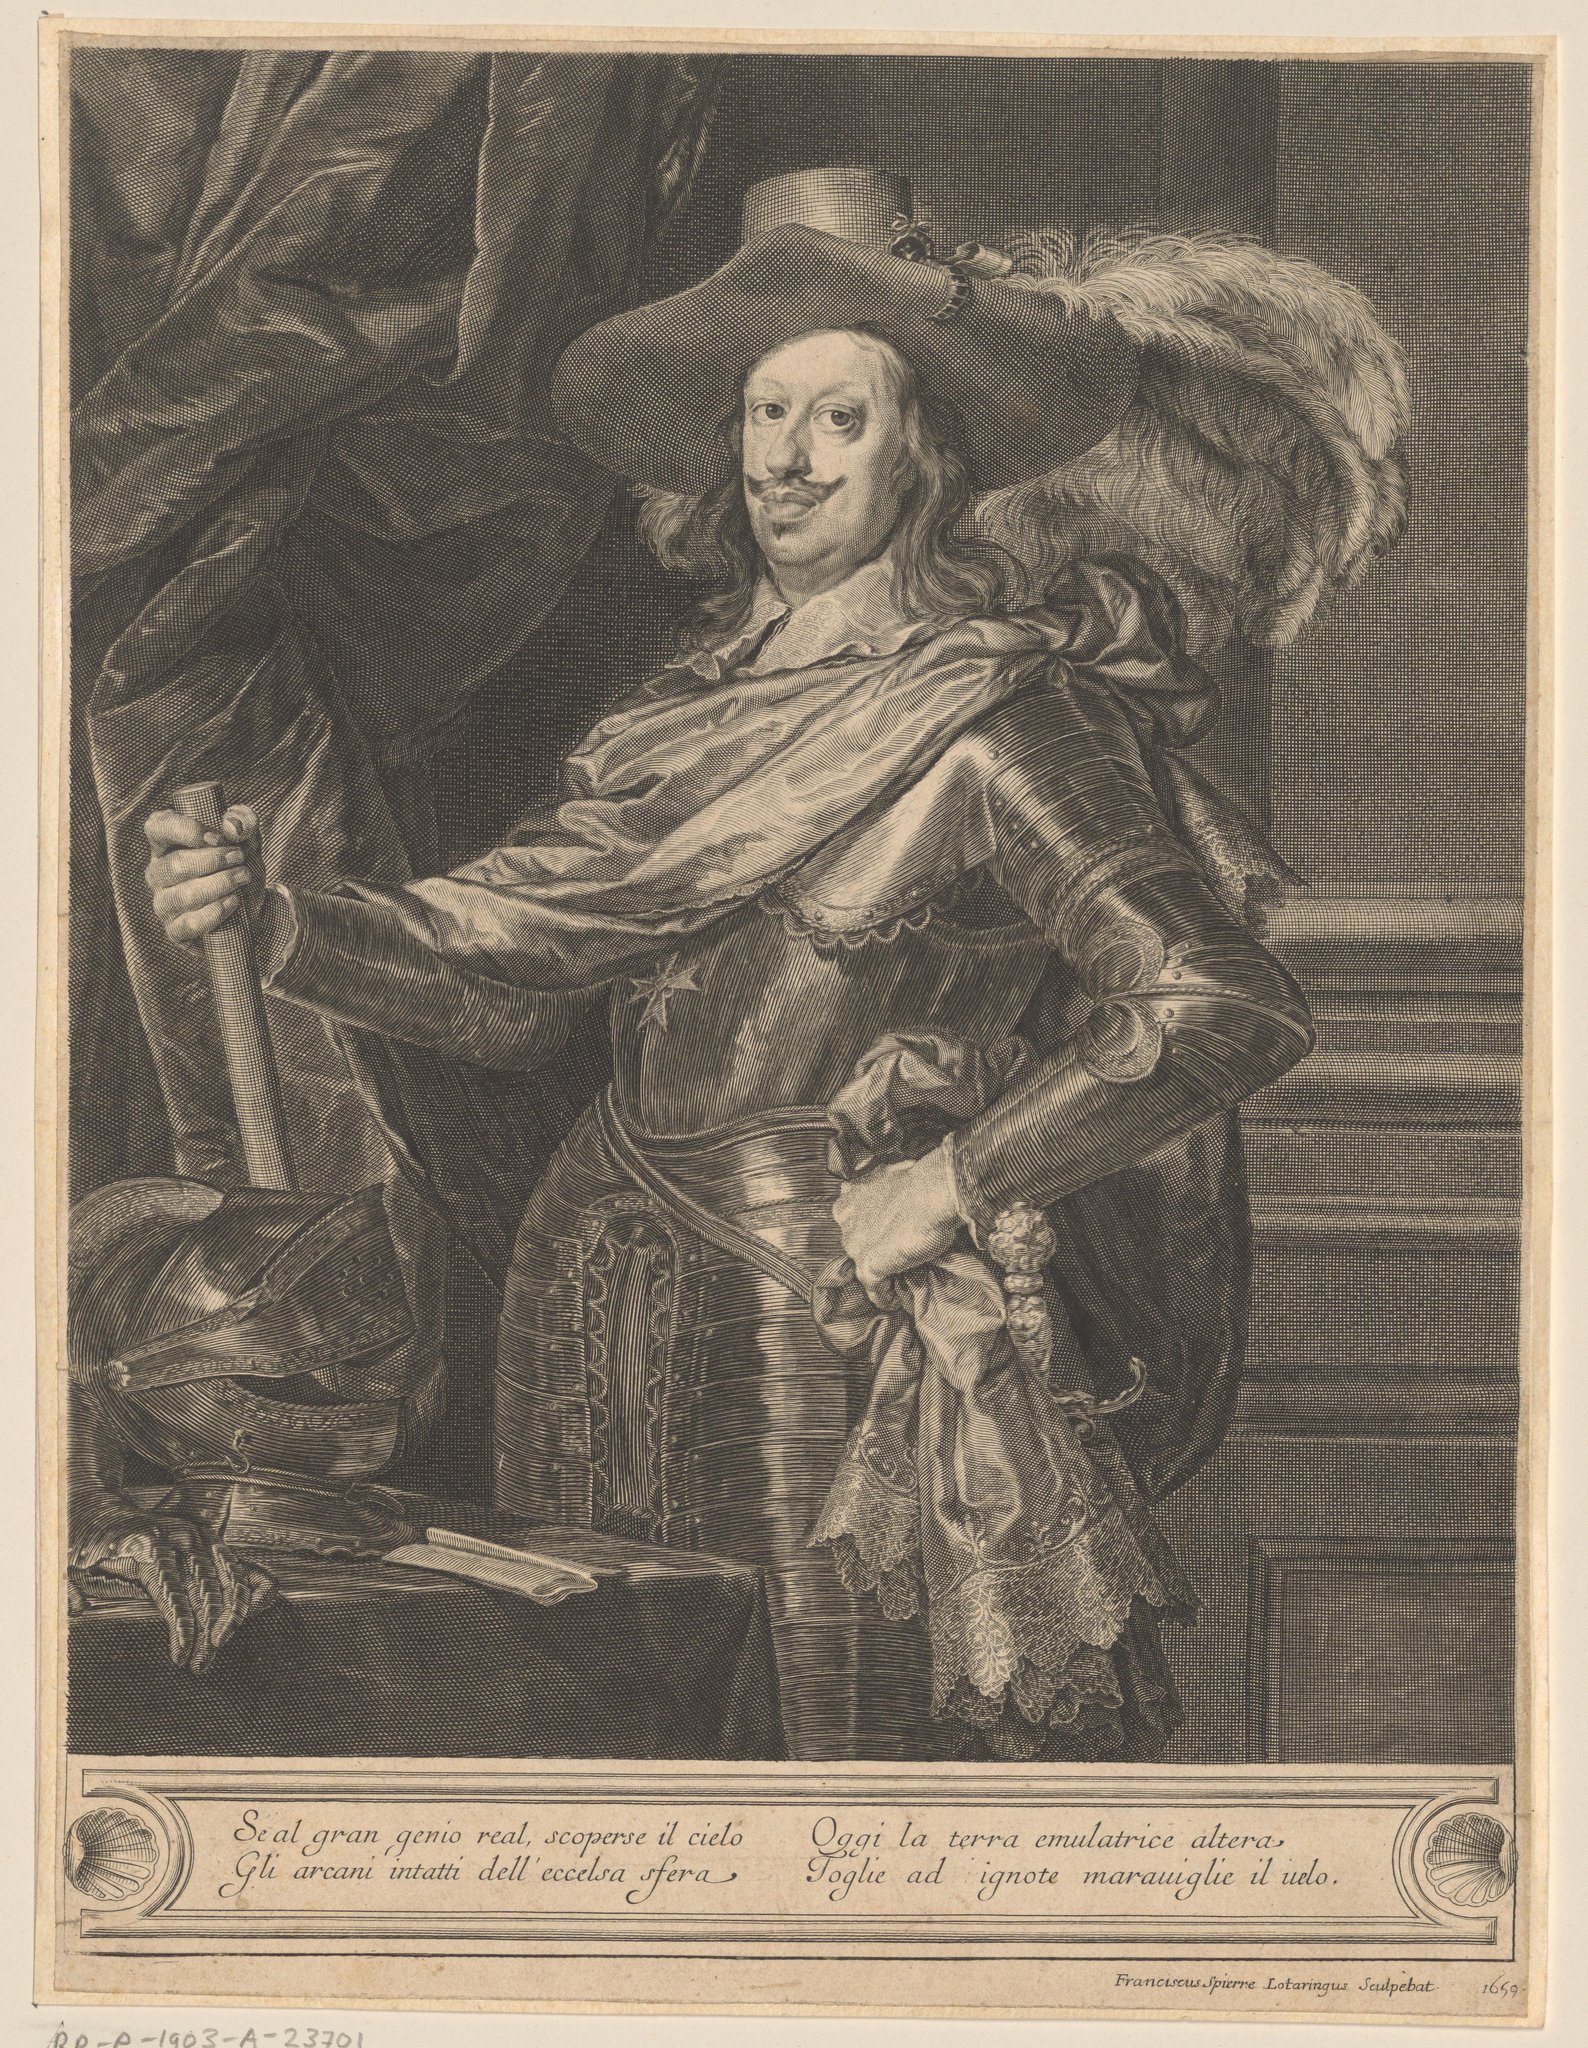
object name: print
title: Portret van Ferdinando II de' Medici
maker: françois spierre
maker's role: print maker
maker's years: 1639-1681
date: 1659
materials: paper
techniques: engraving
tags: ferdinando ii de' medici, helmet, armour, historical persons, scallop, shell ~ ornament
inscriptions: collector's mark: Lugt 567, collector's mark: Lugt 2228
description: Met vierregelig vers in het Italiaans onder het portret.